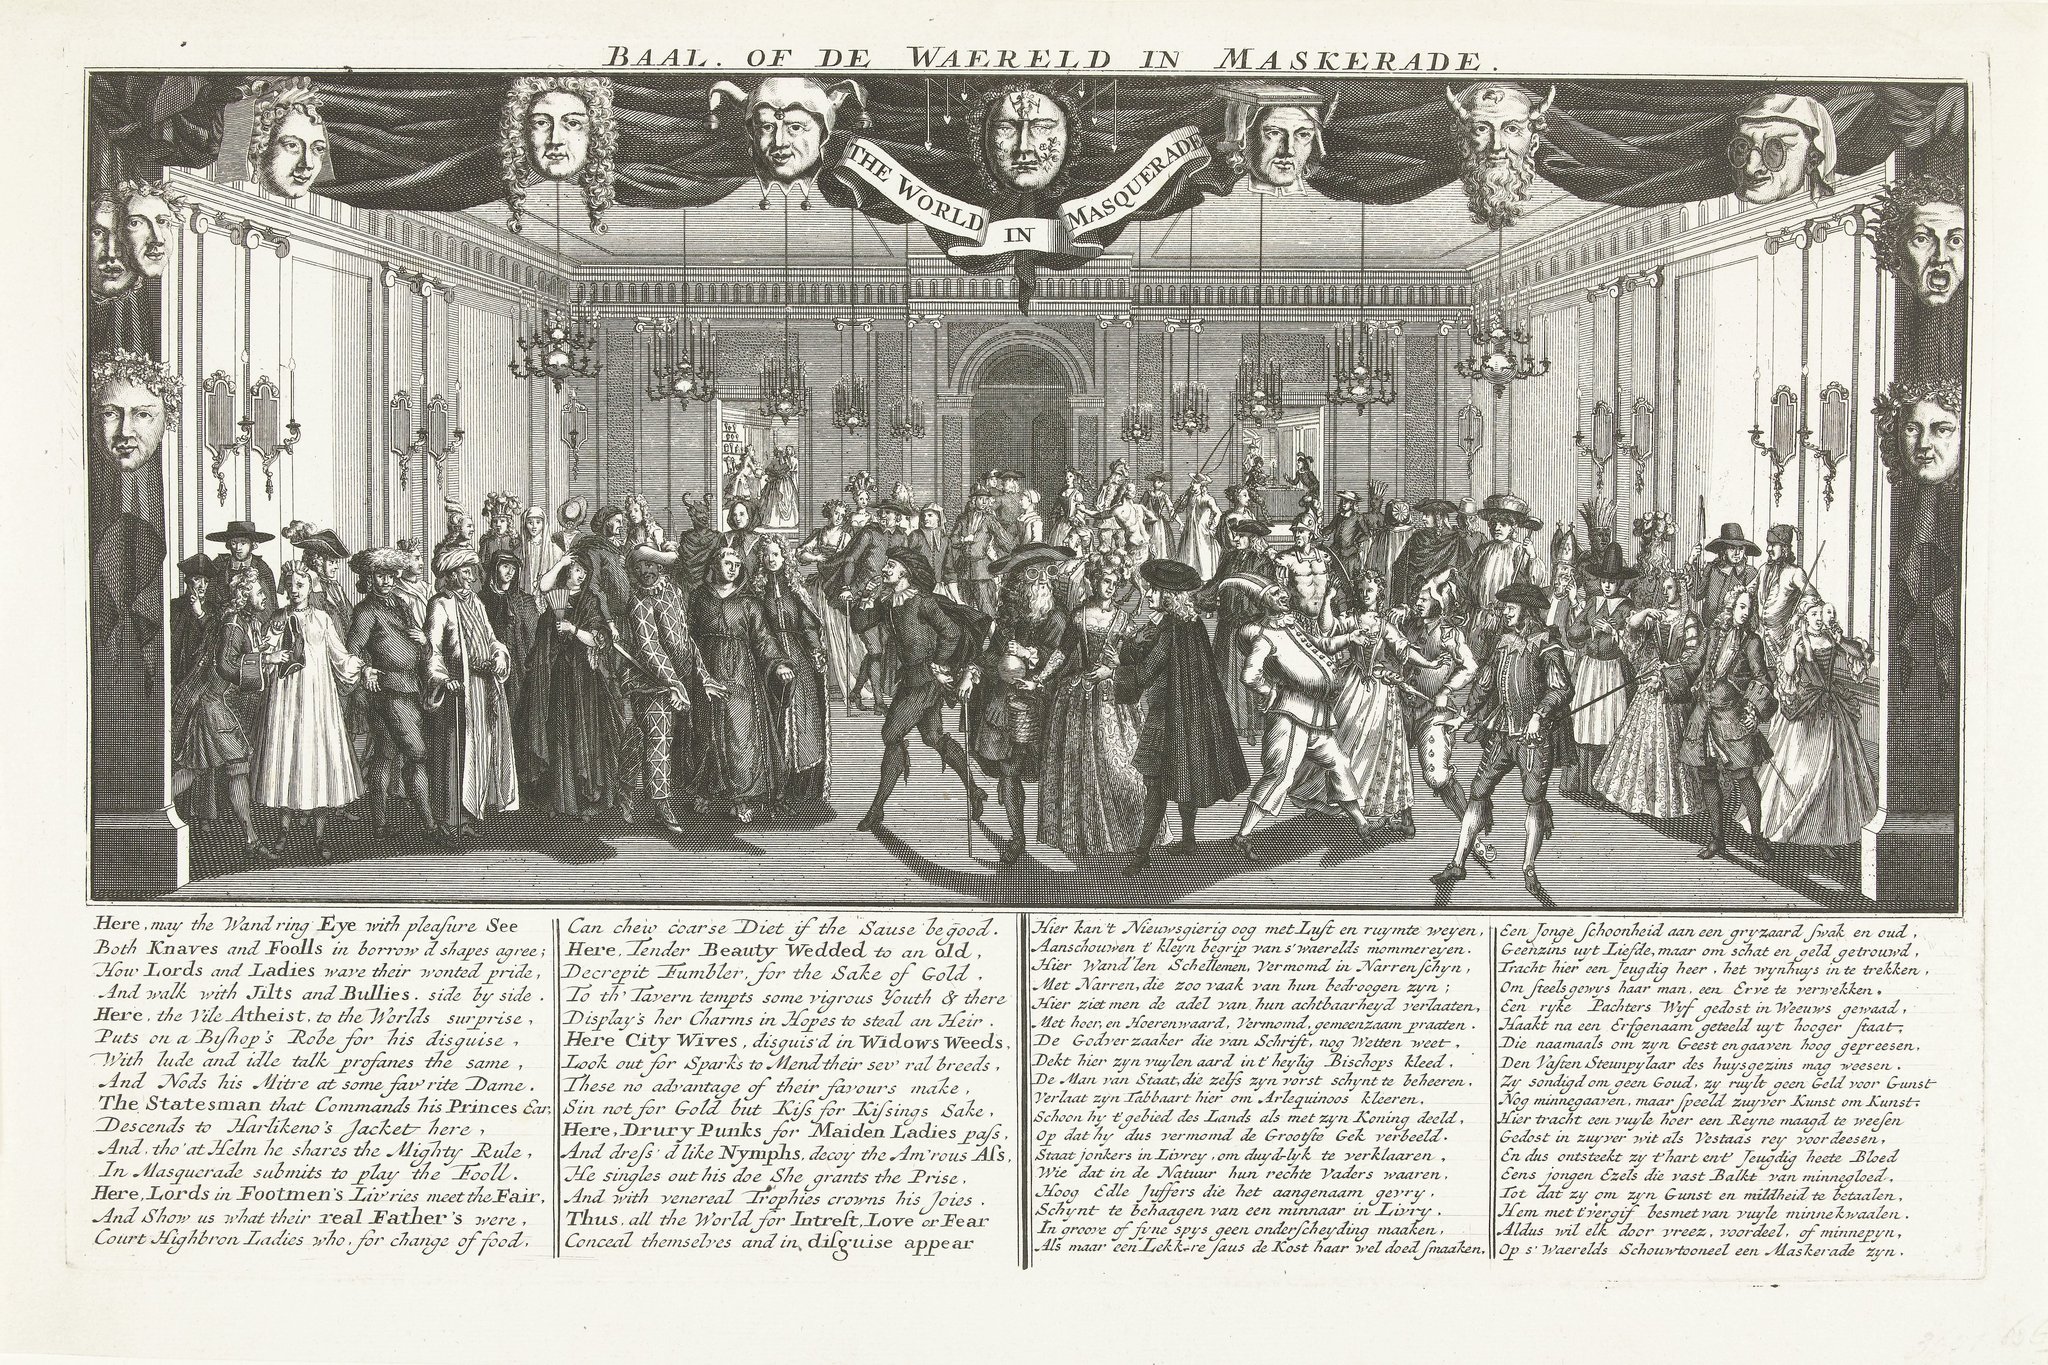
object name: print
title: Bal, of de Wereld in Maskerade, 1720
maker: Anonymous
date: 1720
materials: paper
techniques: engraving, etching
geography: northern netherlands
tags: masquerade, masked ball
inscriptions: collector's mark: Lugt 2228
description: Bal, of de Wereld in Maskerade. Toneel met een danszaal waarin een gemaskerd bal gevierd wordt. Aan de zijkanten en boven het toneel hangen elf maskers, waaronder die van de duivel, een nar etc. Met onderschrift in vier kolommen in het Engels en Nederlands. Prent 66 in de serie Tafereel der Dwaasheid met spotprenten op de Windhandel of Actiehandel van 1720, al heeft de prent waarschijnlijk niets te maken met de windhandel.